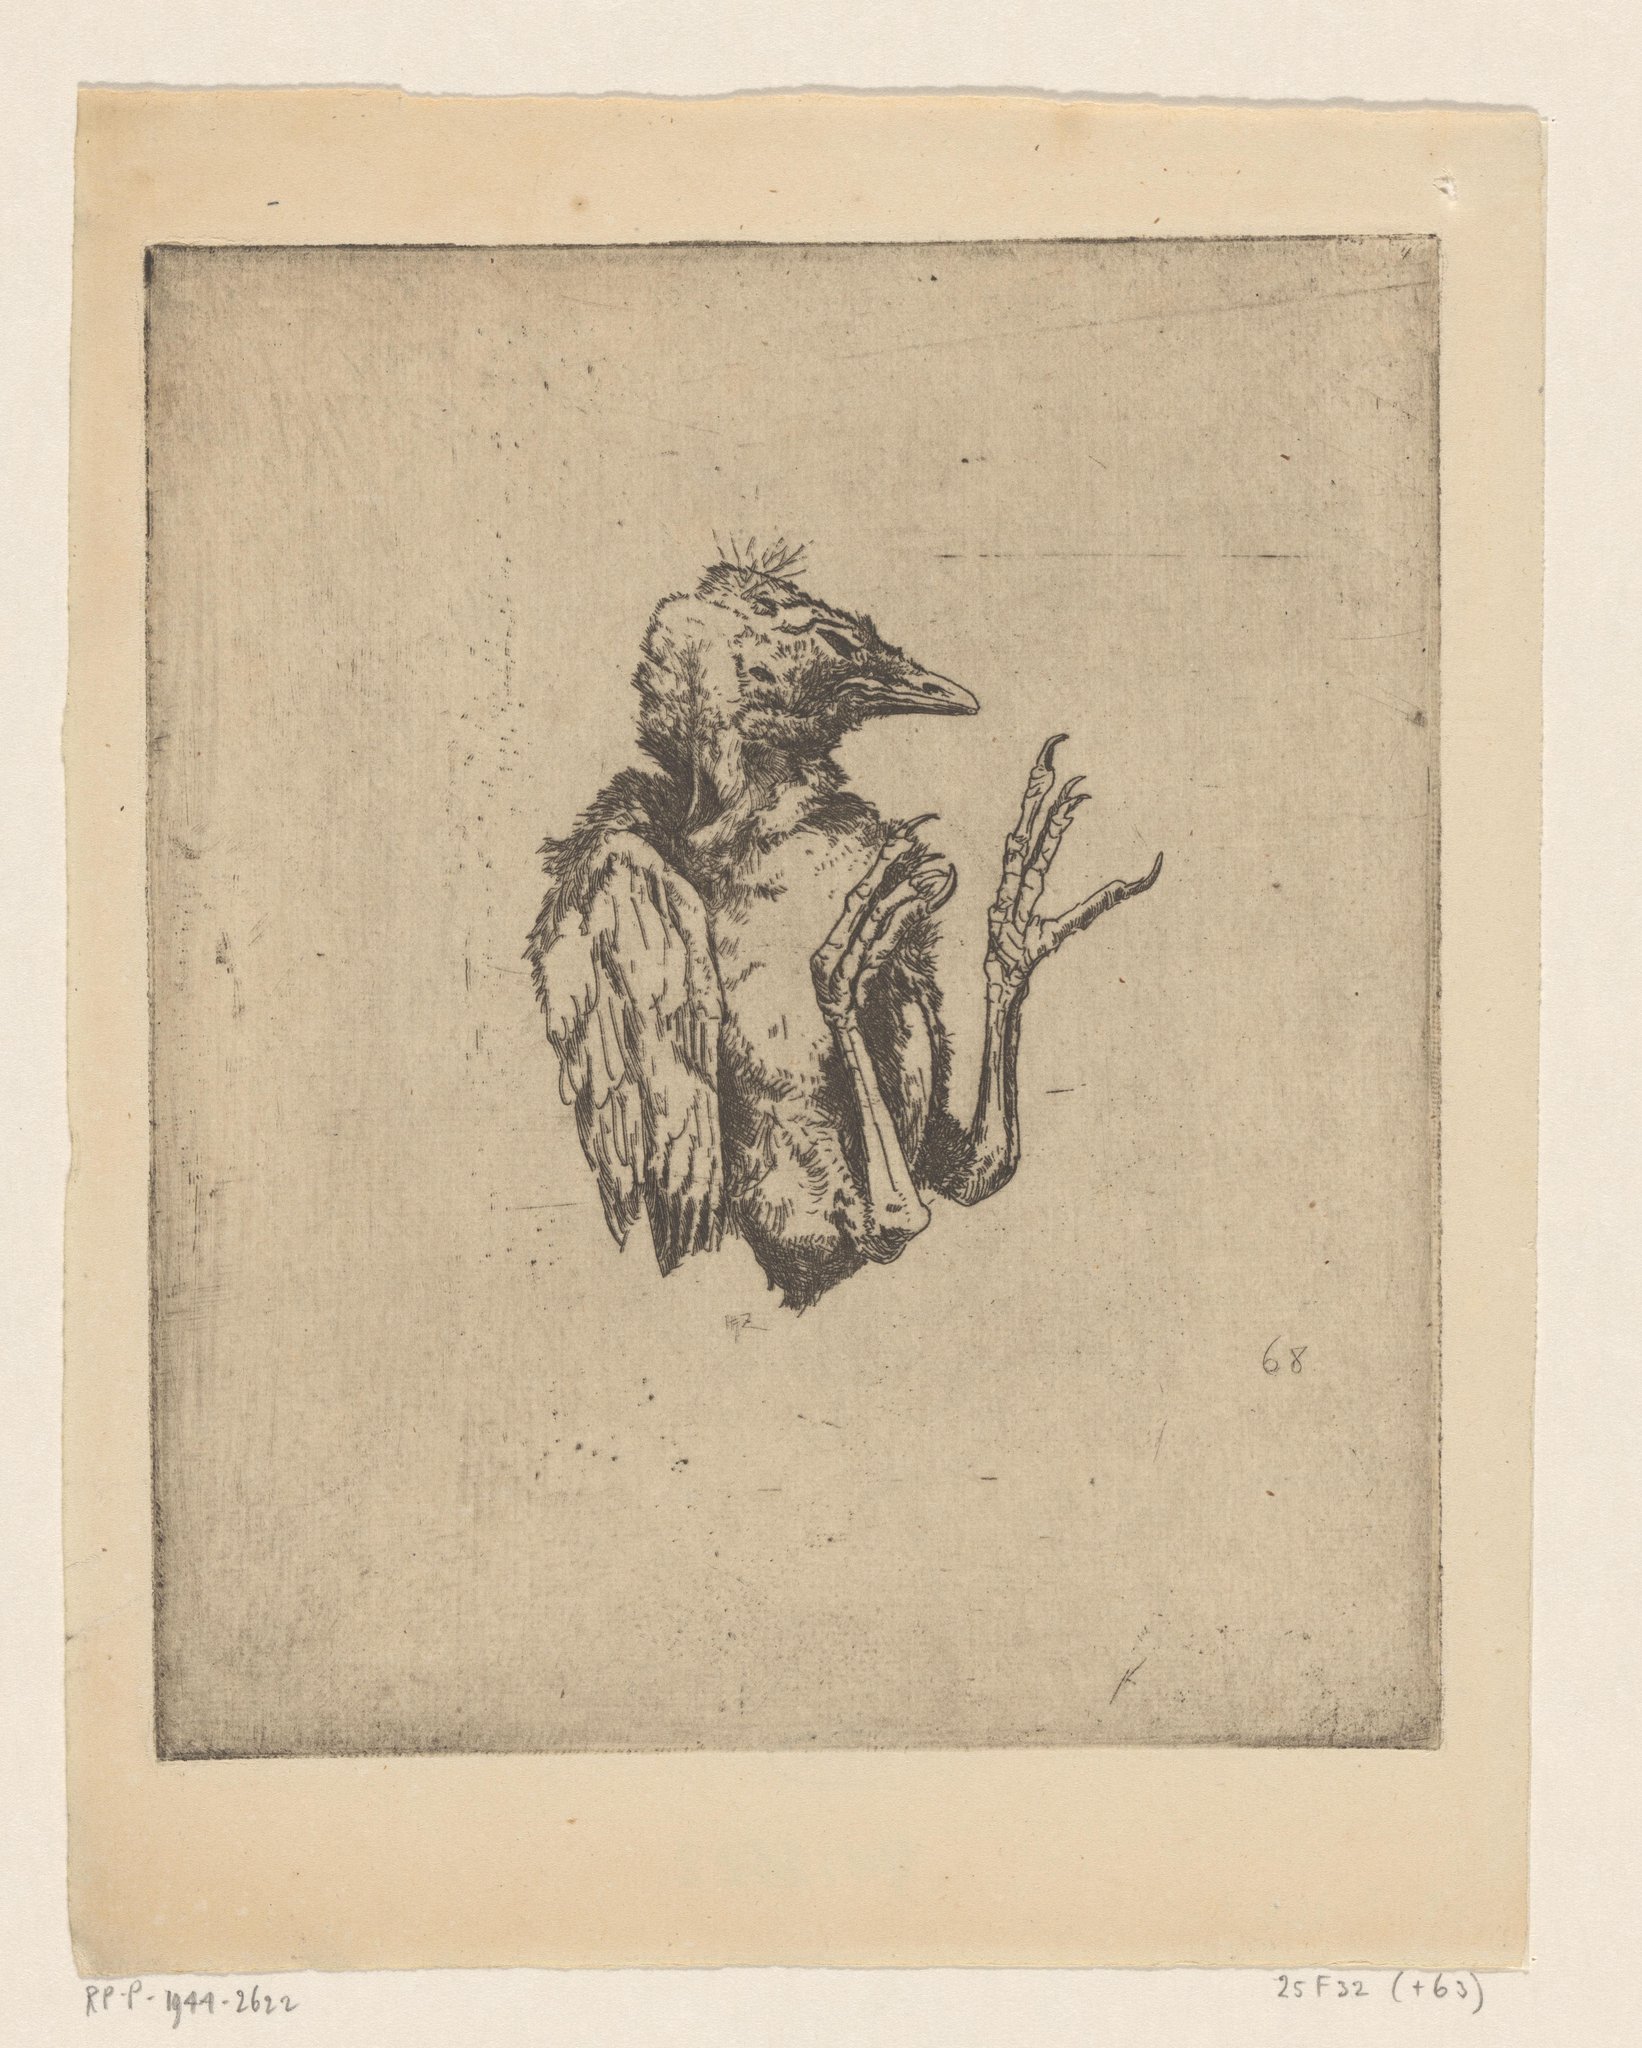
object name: print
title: Jeune oiseau mort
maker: philip zilcken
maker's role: draughtsman, painter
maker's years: 1857-1930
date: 1867-1888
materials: paper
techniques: drypoint, etching, intaglio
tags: song-birds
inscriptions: collector's mark: Lugt 2228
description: Prent verscheen in 1888 als onderdeel van de jaarlijkse uitgave van de 'Portefeuille der Nederlandsche Etsclub'.